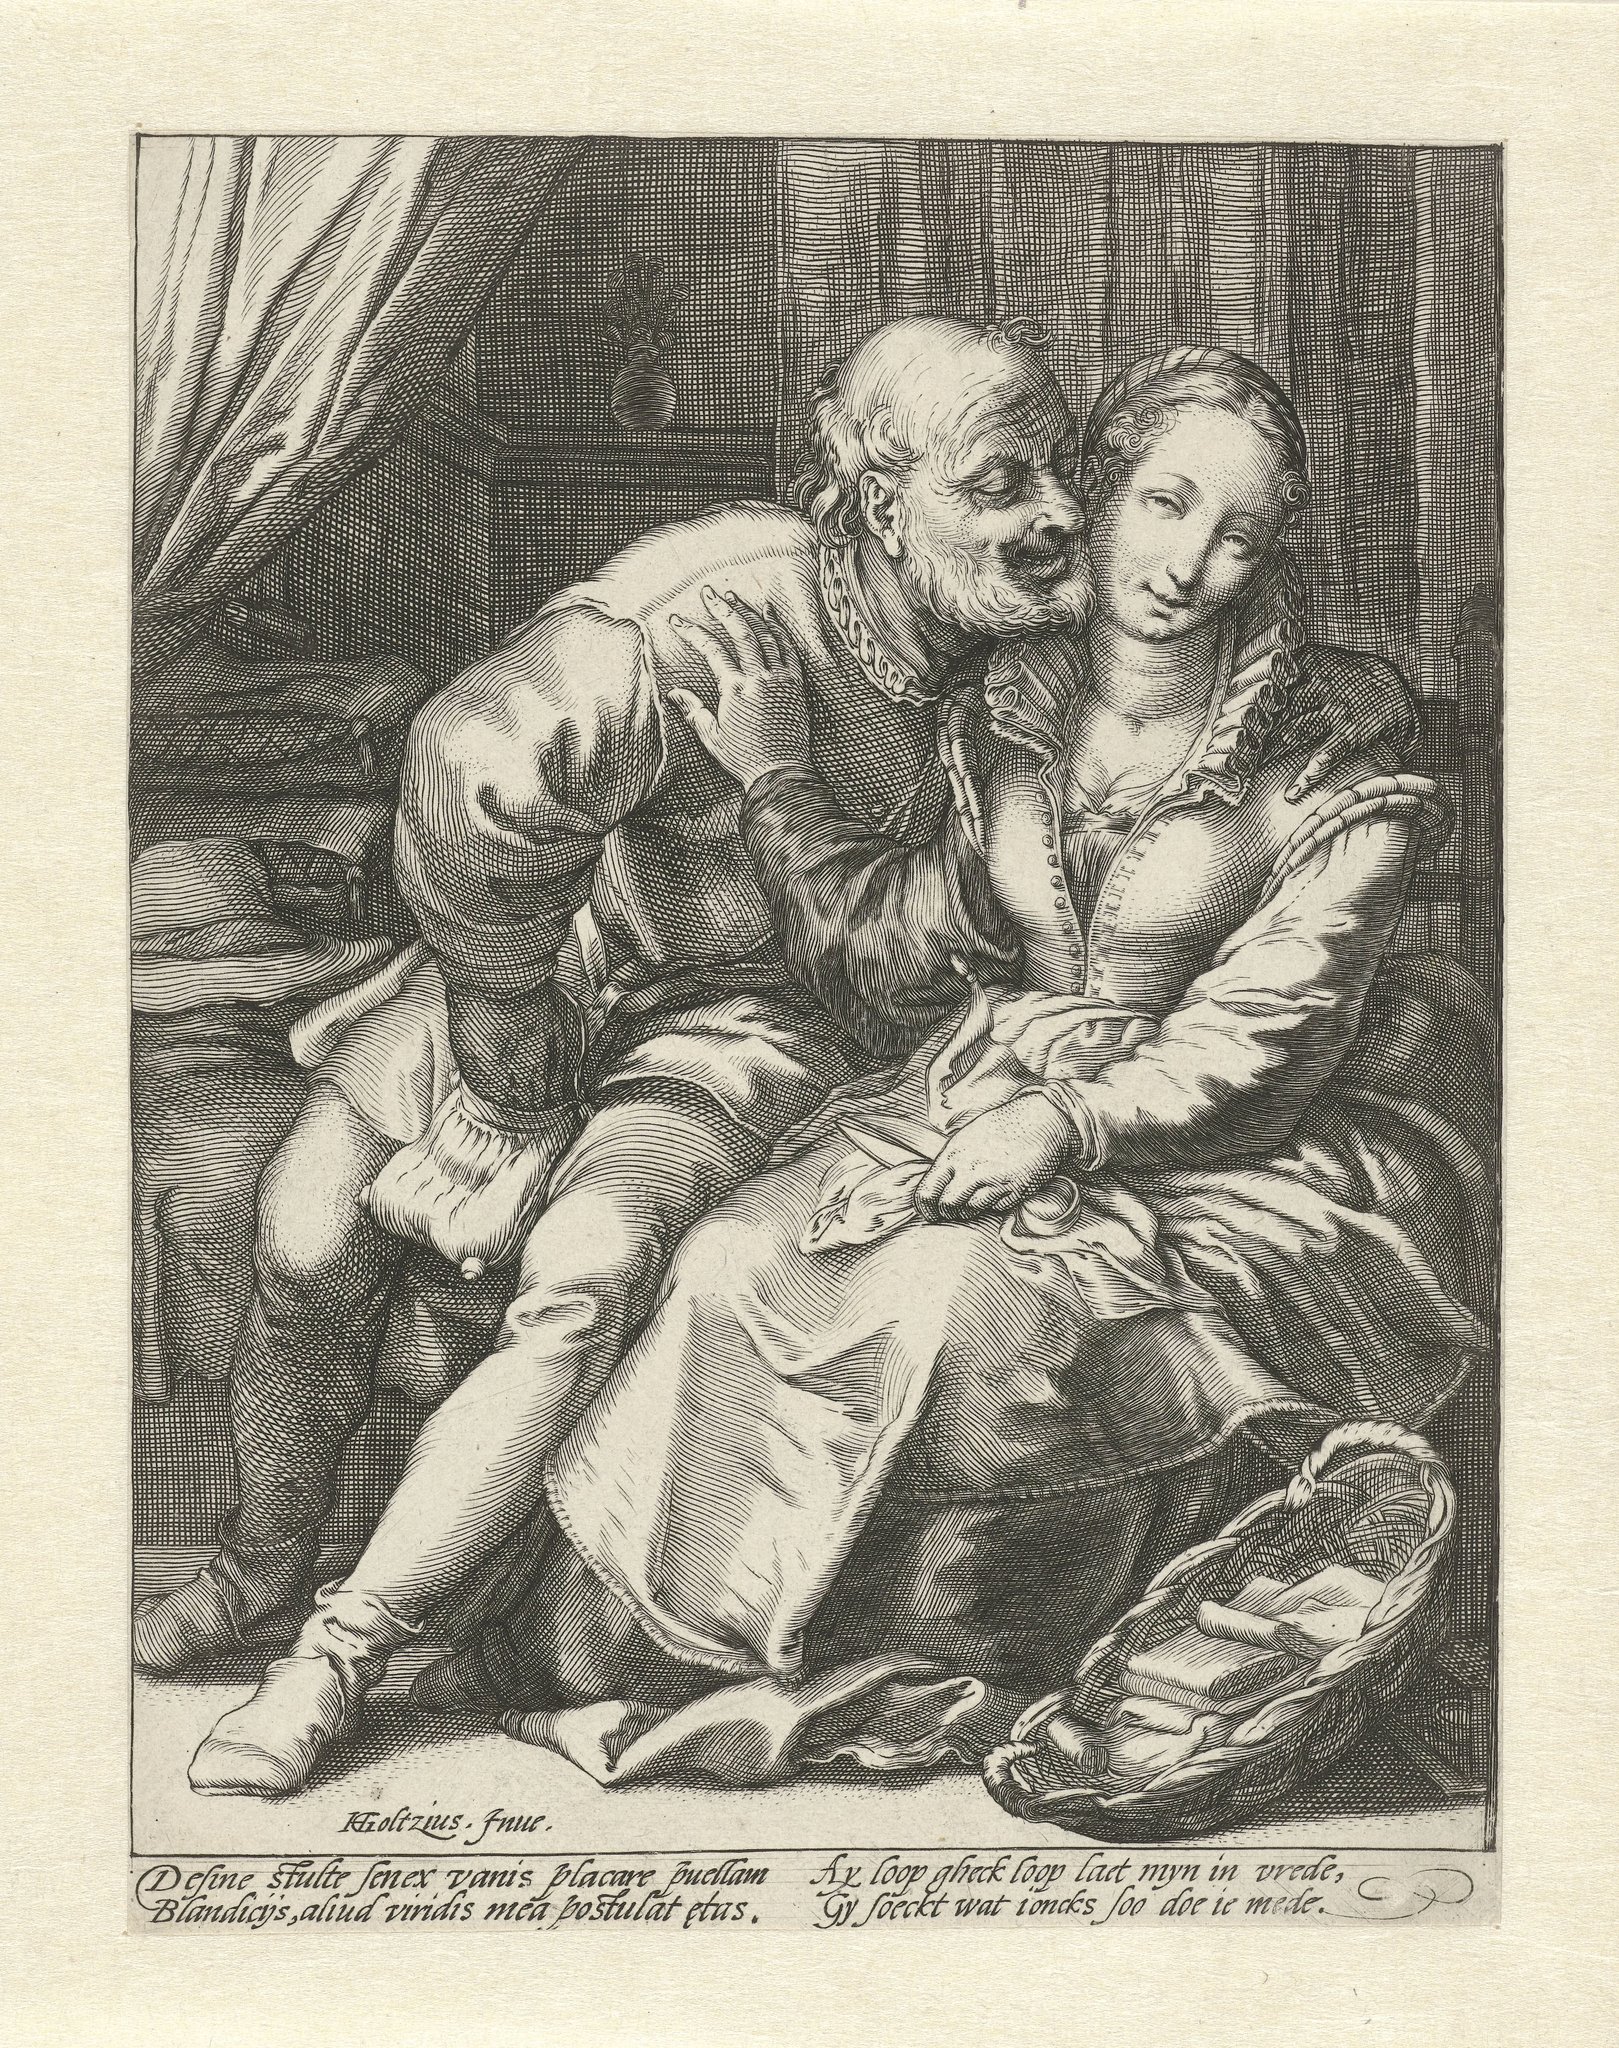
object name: print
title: Afwijzing van een oude man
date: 1584-1630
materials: paper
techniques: engraving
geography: haarlem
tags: purse, money-bag, one-sided courting; pursuit; difficult choice, married couple of unequal age, young versus old age; young and old, adolescent, young woman, maiden (+ old male (human being)), ugly old man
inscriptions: collector's mark: Lugt 2228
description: Een oude man zit op een stoel en tast in zijn geldbuidel. Naast hem een jonge vrouw op een stoel. De oude man probeert de vrouw te kussen, maar zij draait zich weg van hem en houdt hem tegen. De prent heeft een Latijns en Nederlands onderschrift